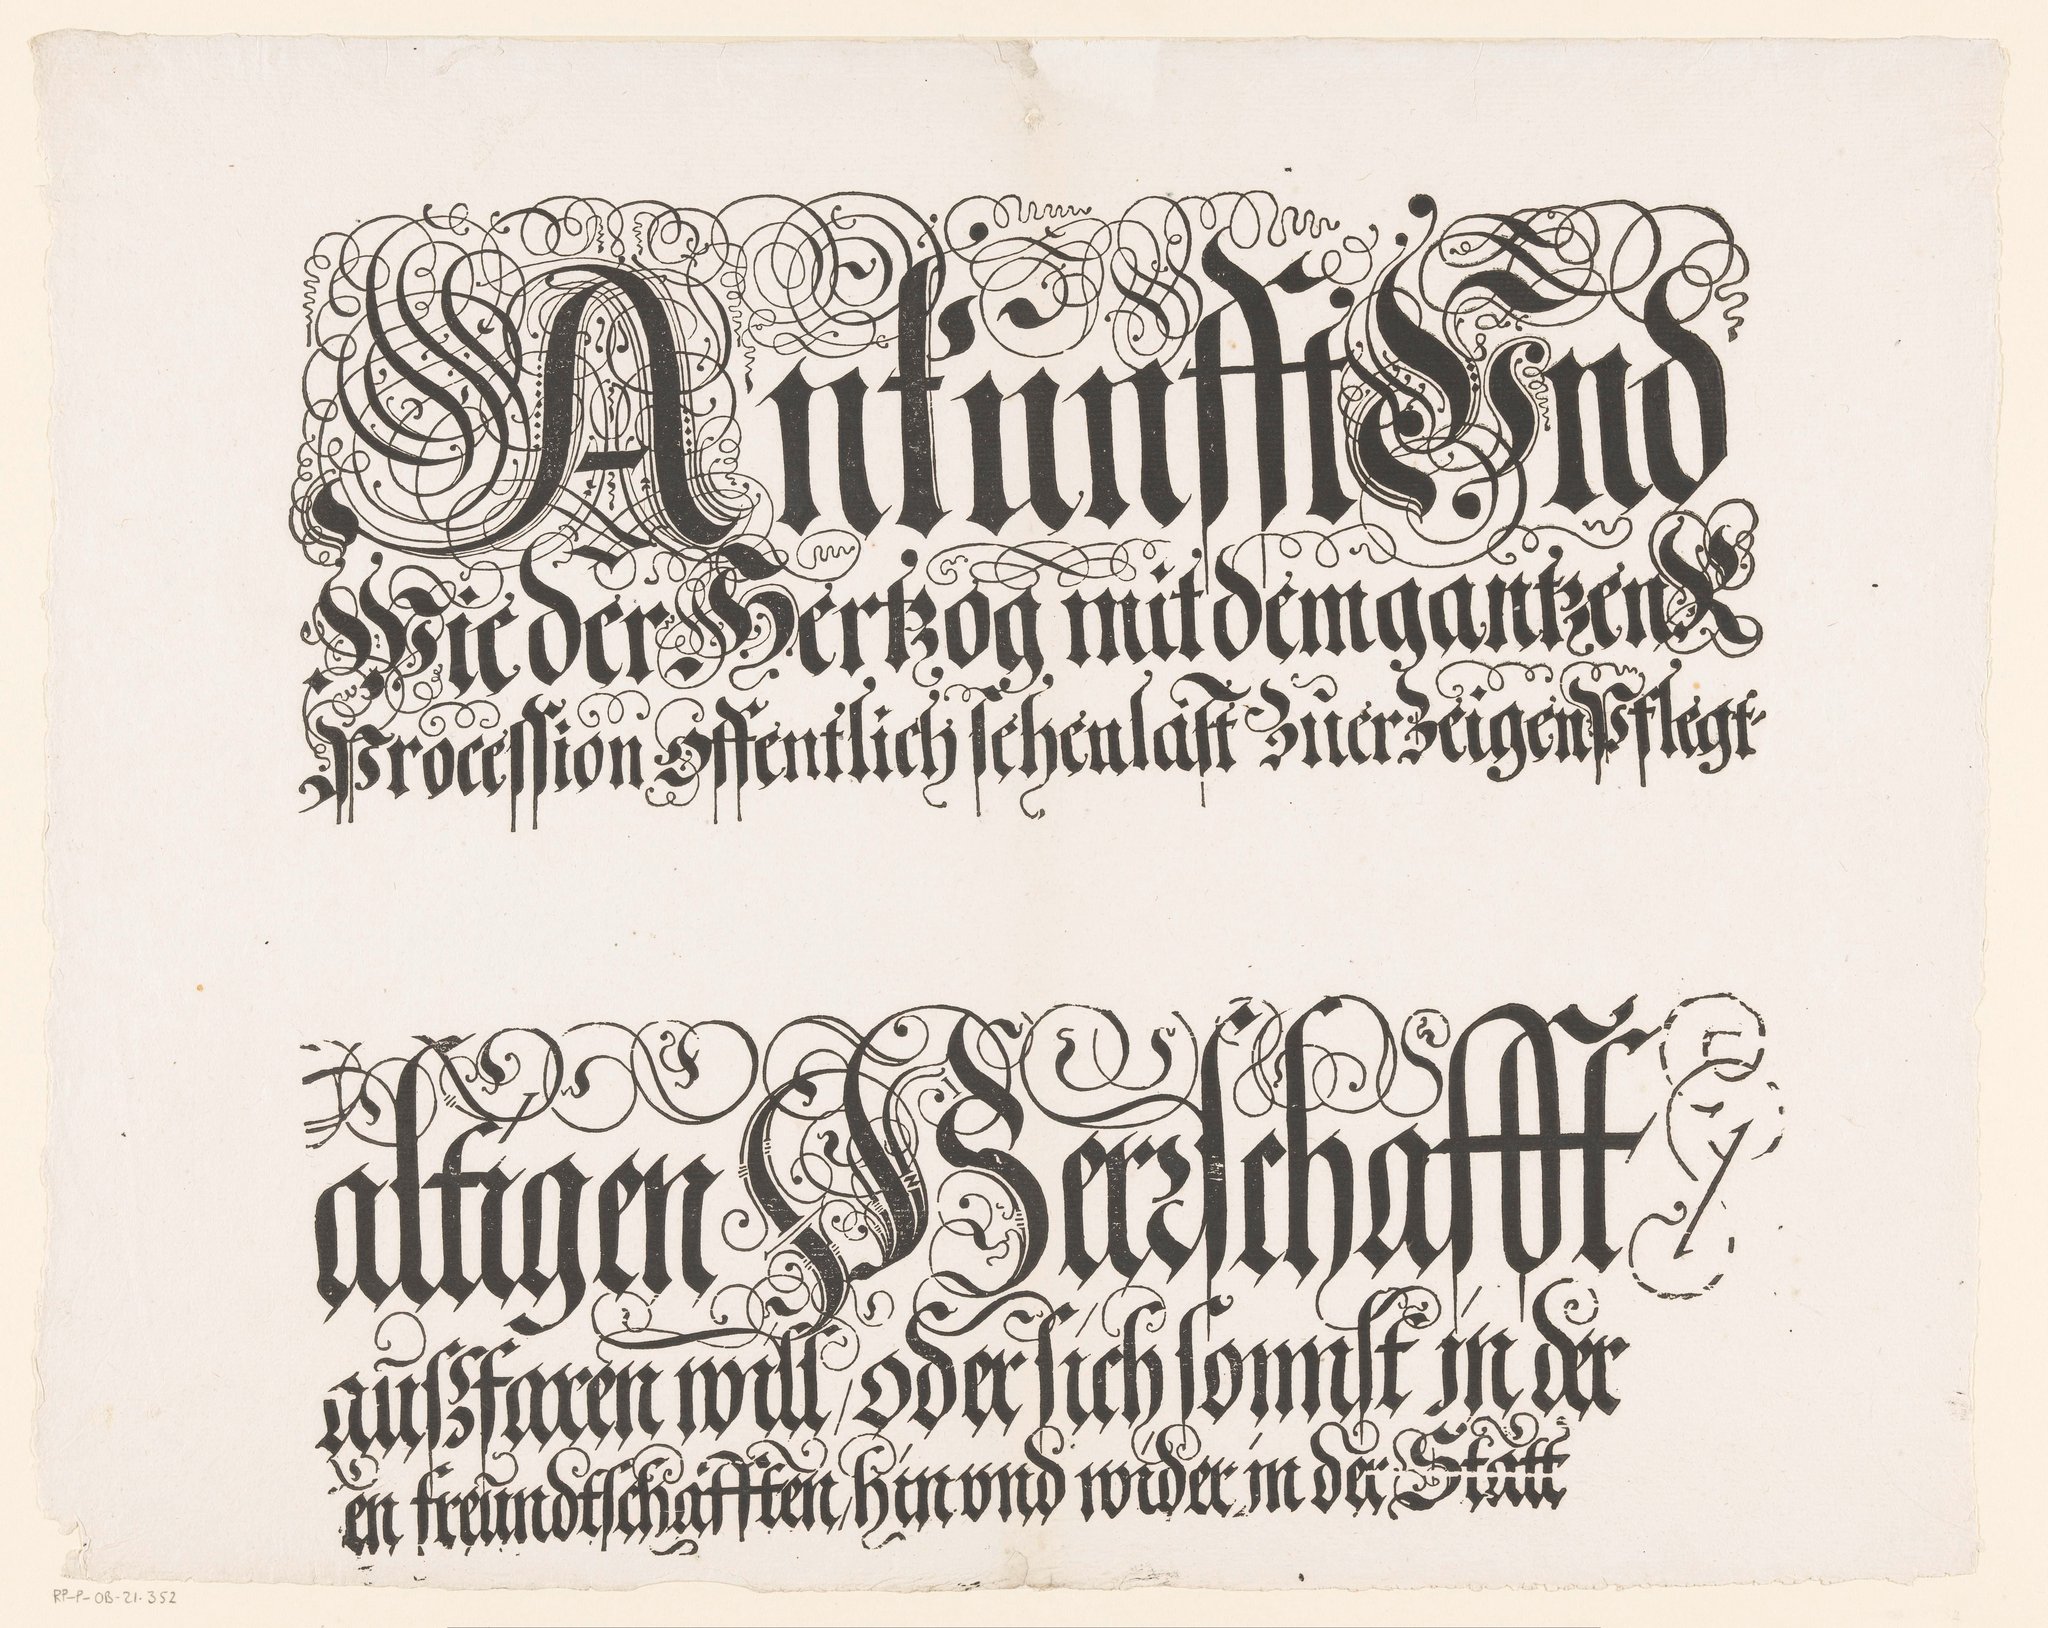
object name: text sheet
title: Titel van de Festa della Sensa (eerste en vijfde gedeelte)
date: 1697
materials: paper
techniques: woodcut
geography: frankfurt am main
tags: city-view in general; 'veduta', procession ~ christian religion, other sovereign: doge, gondola, venice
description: Eerste gedeelte van een titel behorende bij een prent van de Festa della Sensa. De voorstelling is gedrukt van veertien blokken, de titel van vijf blokken en het onderschrift bestaat uit vijf delen van elk drie kolommen Duits tekst. In de collectie Rijksmuseum bevinden zich twee complete exemplaren inclusief titel en onderschrift. Omdat niet alle delen van de titel en het onderschrift op afzonderlijke bladen zijn gedrukt, is dit exemplaar niet virtueel samengevoegd omwille van een betere presentatie. Zie voor het andere exemplaar: RP-P-2017-6073.